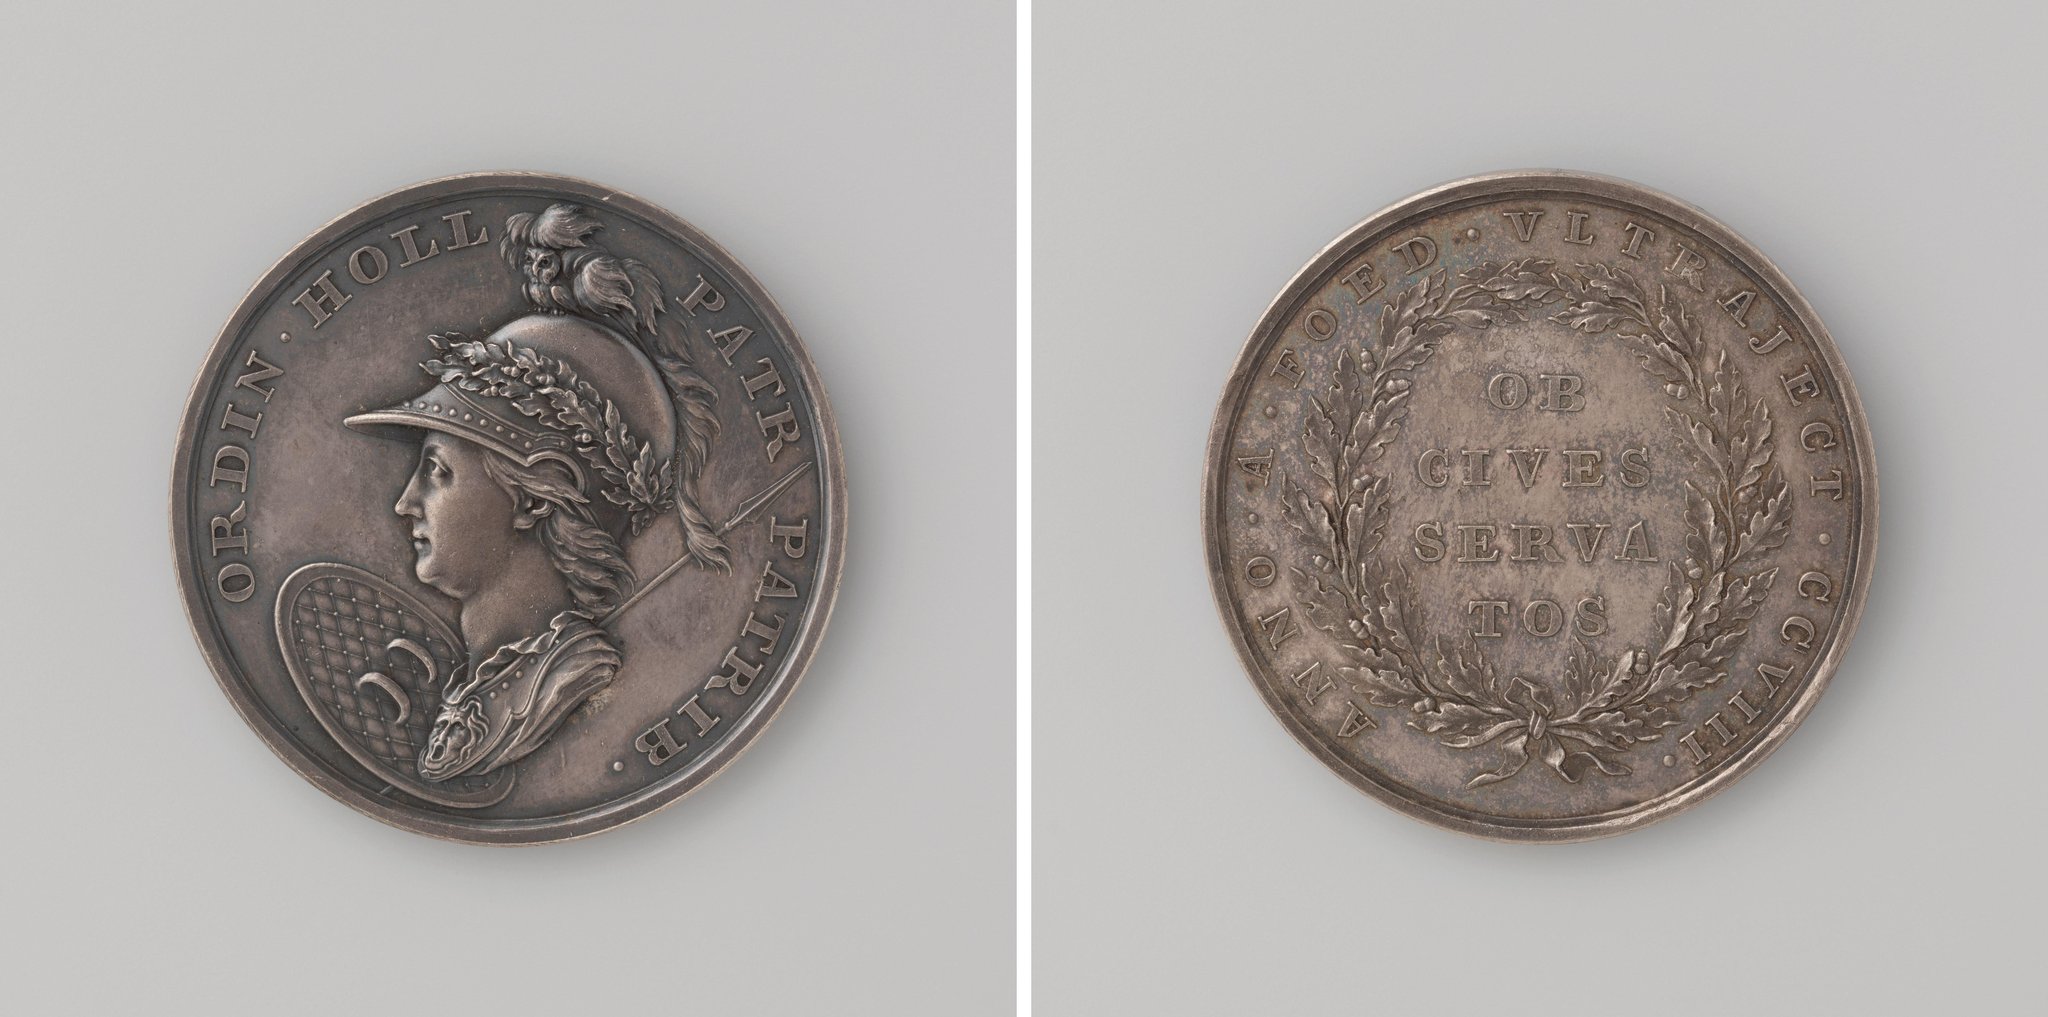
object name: honorary medal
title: Door de gewapende patriotten van Utrecht de Staten van Holland toegedacht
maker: theodorus victor van berckel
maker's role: mintmaster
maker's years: 1739-1808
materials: silver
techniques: striking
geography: brussels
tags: utrecht, holland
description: Zilveren penning. Voorzijde: Minerva met gepluimde helm, bekroond met eikenkrans tussen schild en speer binnen omschrift. Keerzijde: opschrift binnen eikenkrans en omschrift.